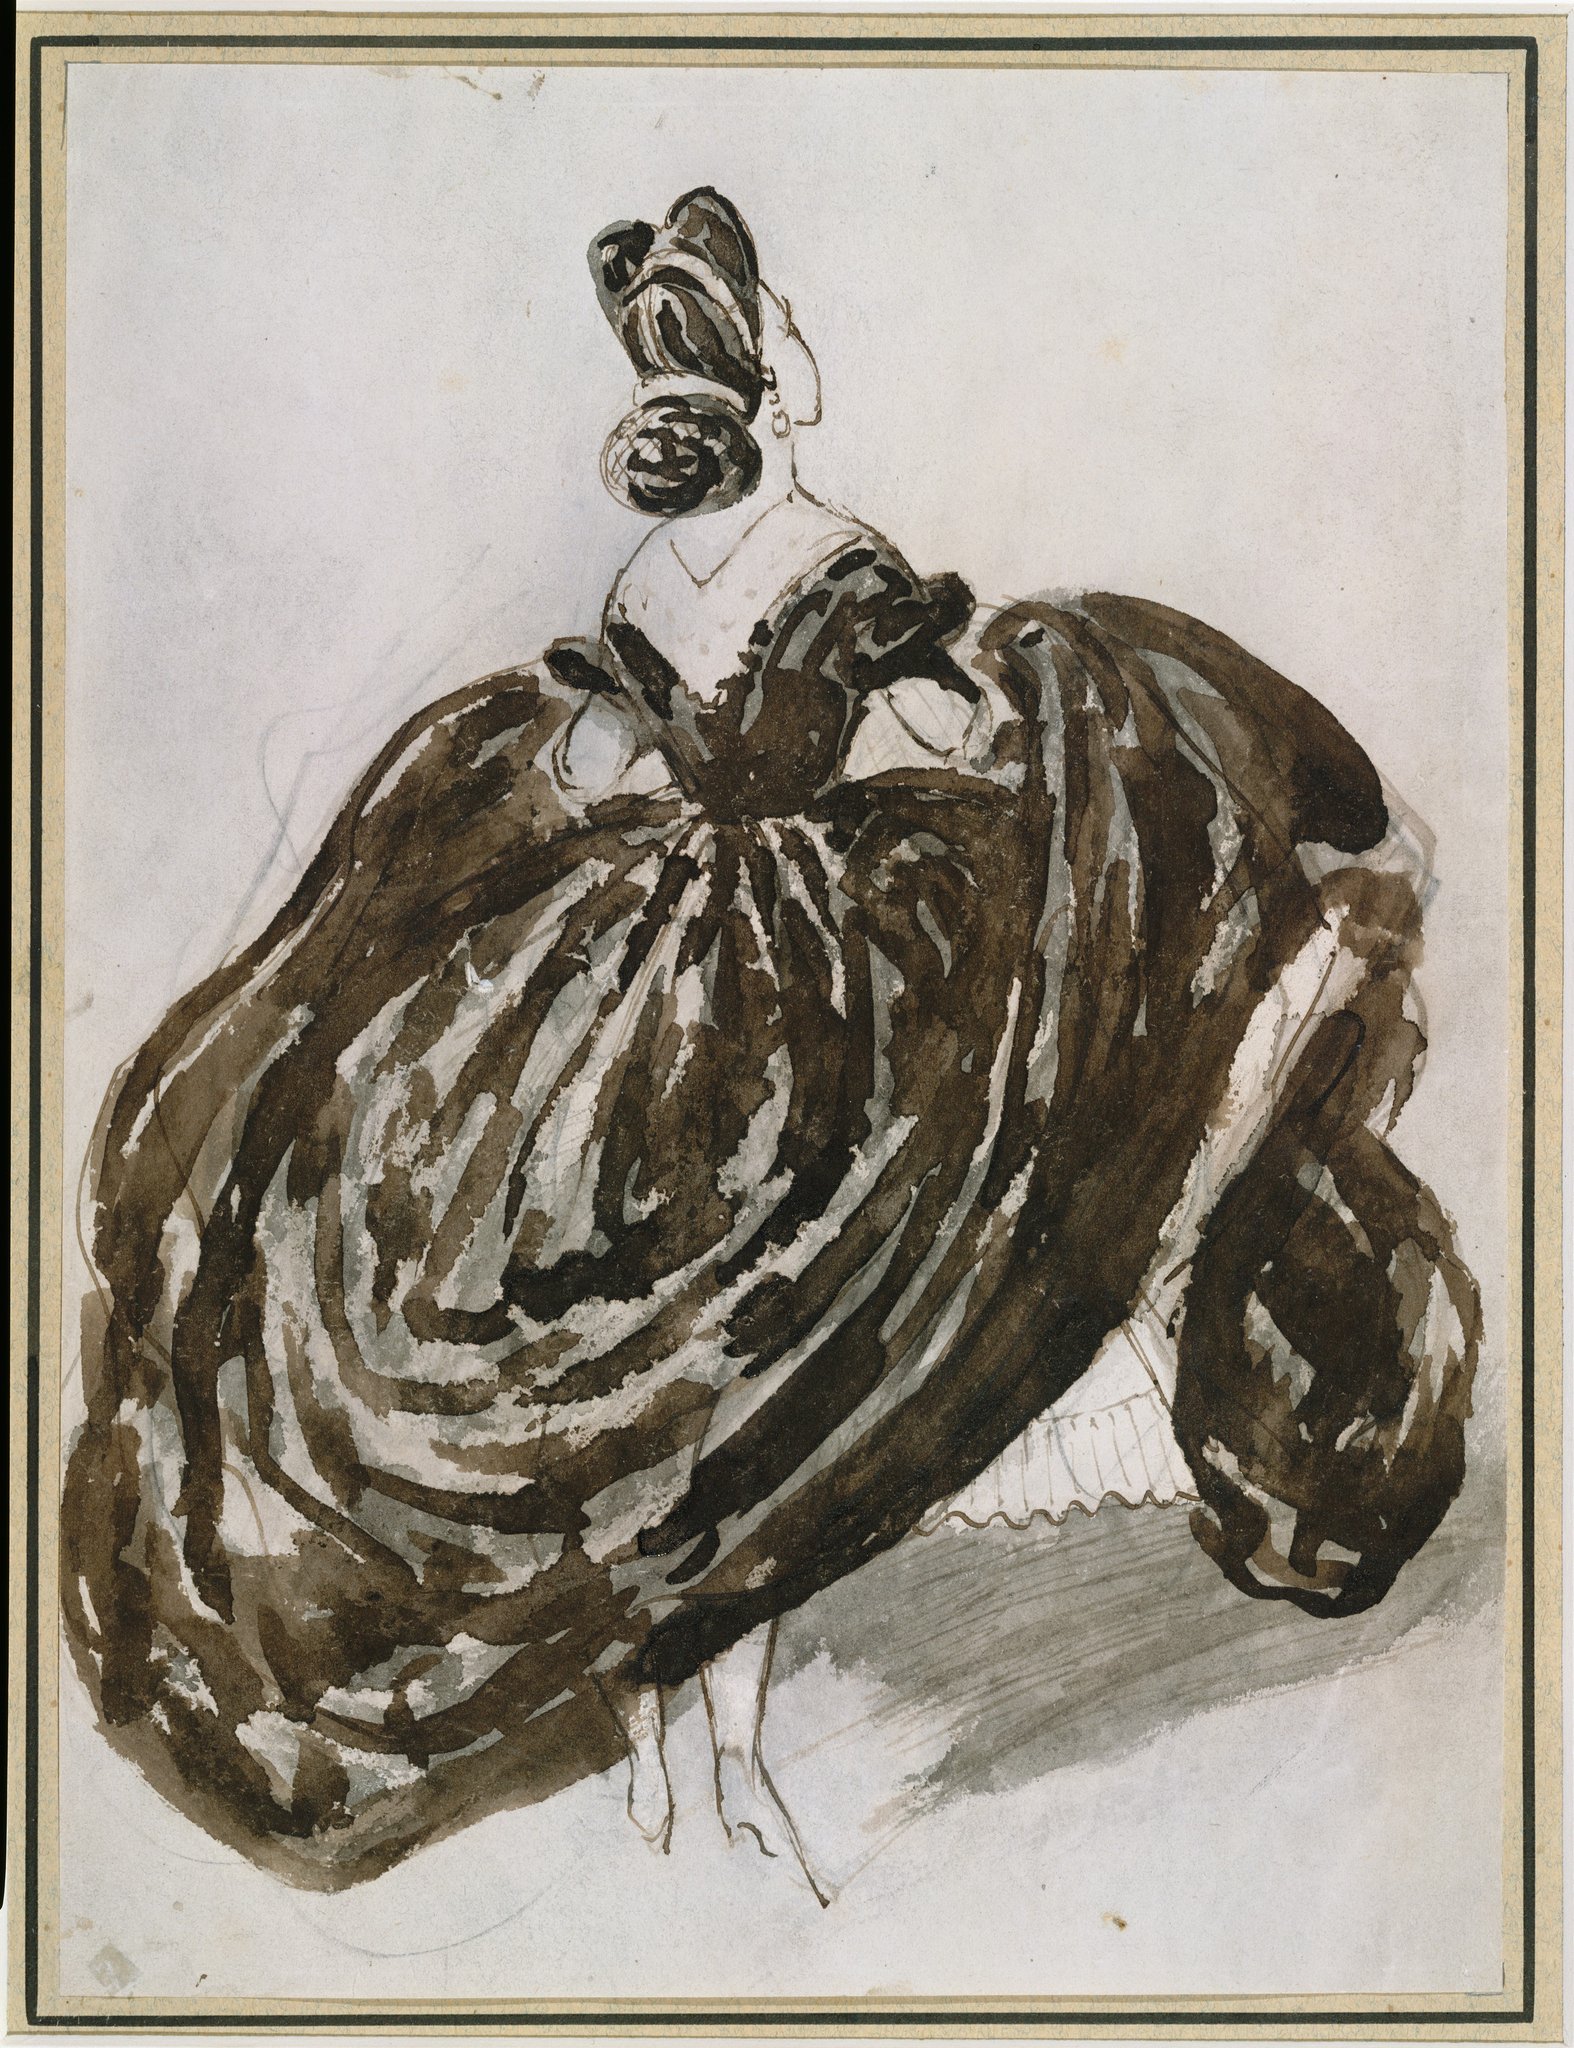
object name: drawing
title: A Parisienne Seen from the Back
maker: constantin guys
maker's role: artist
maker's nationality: french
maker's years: 1802-1892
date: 1850-1859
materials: graphite, ink, paper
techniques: wash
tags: women